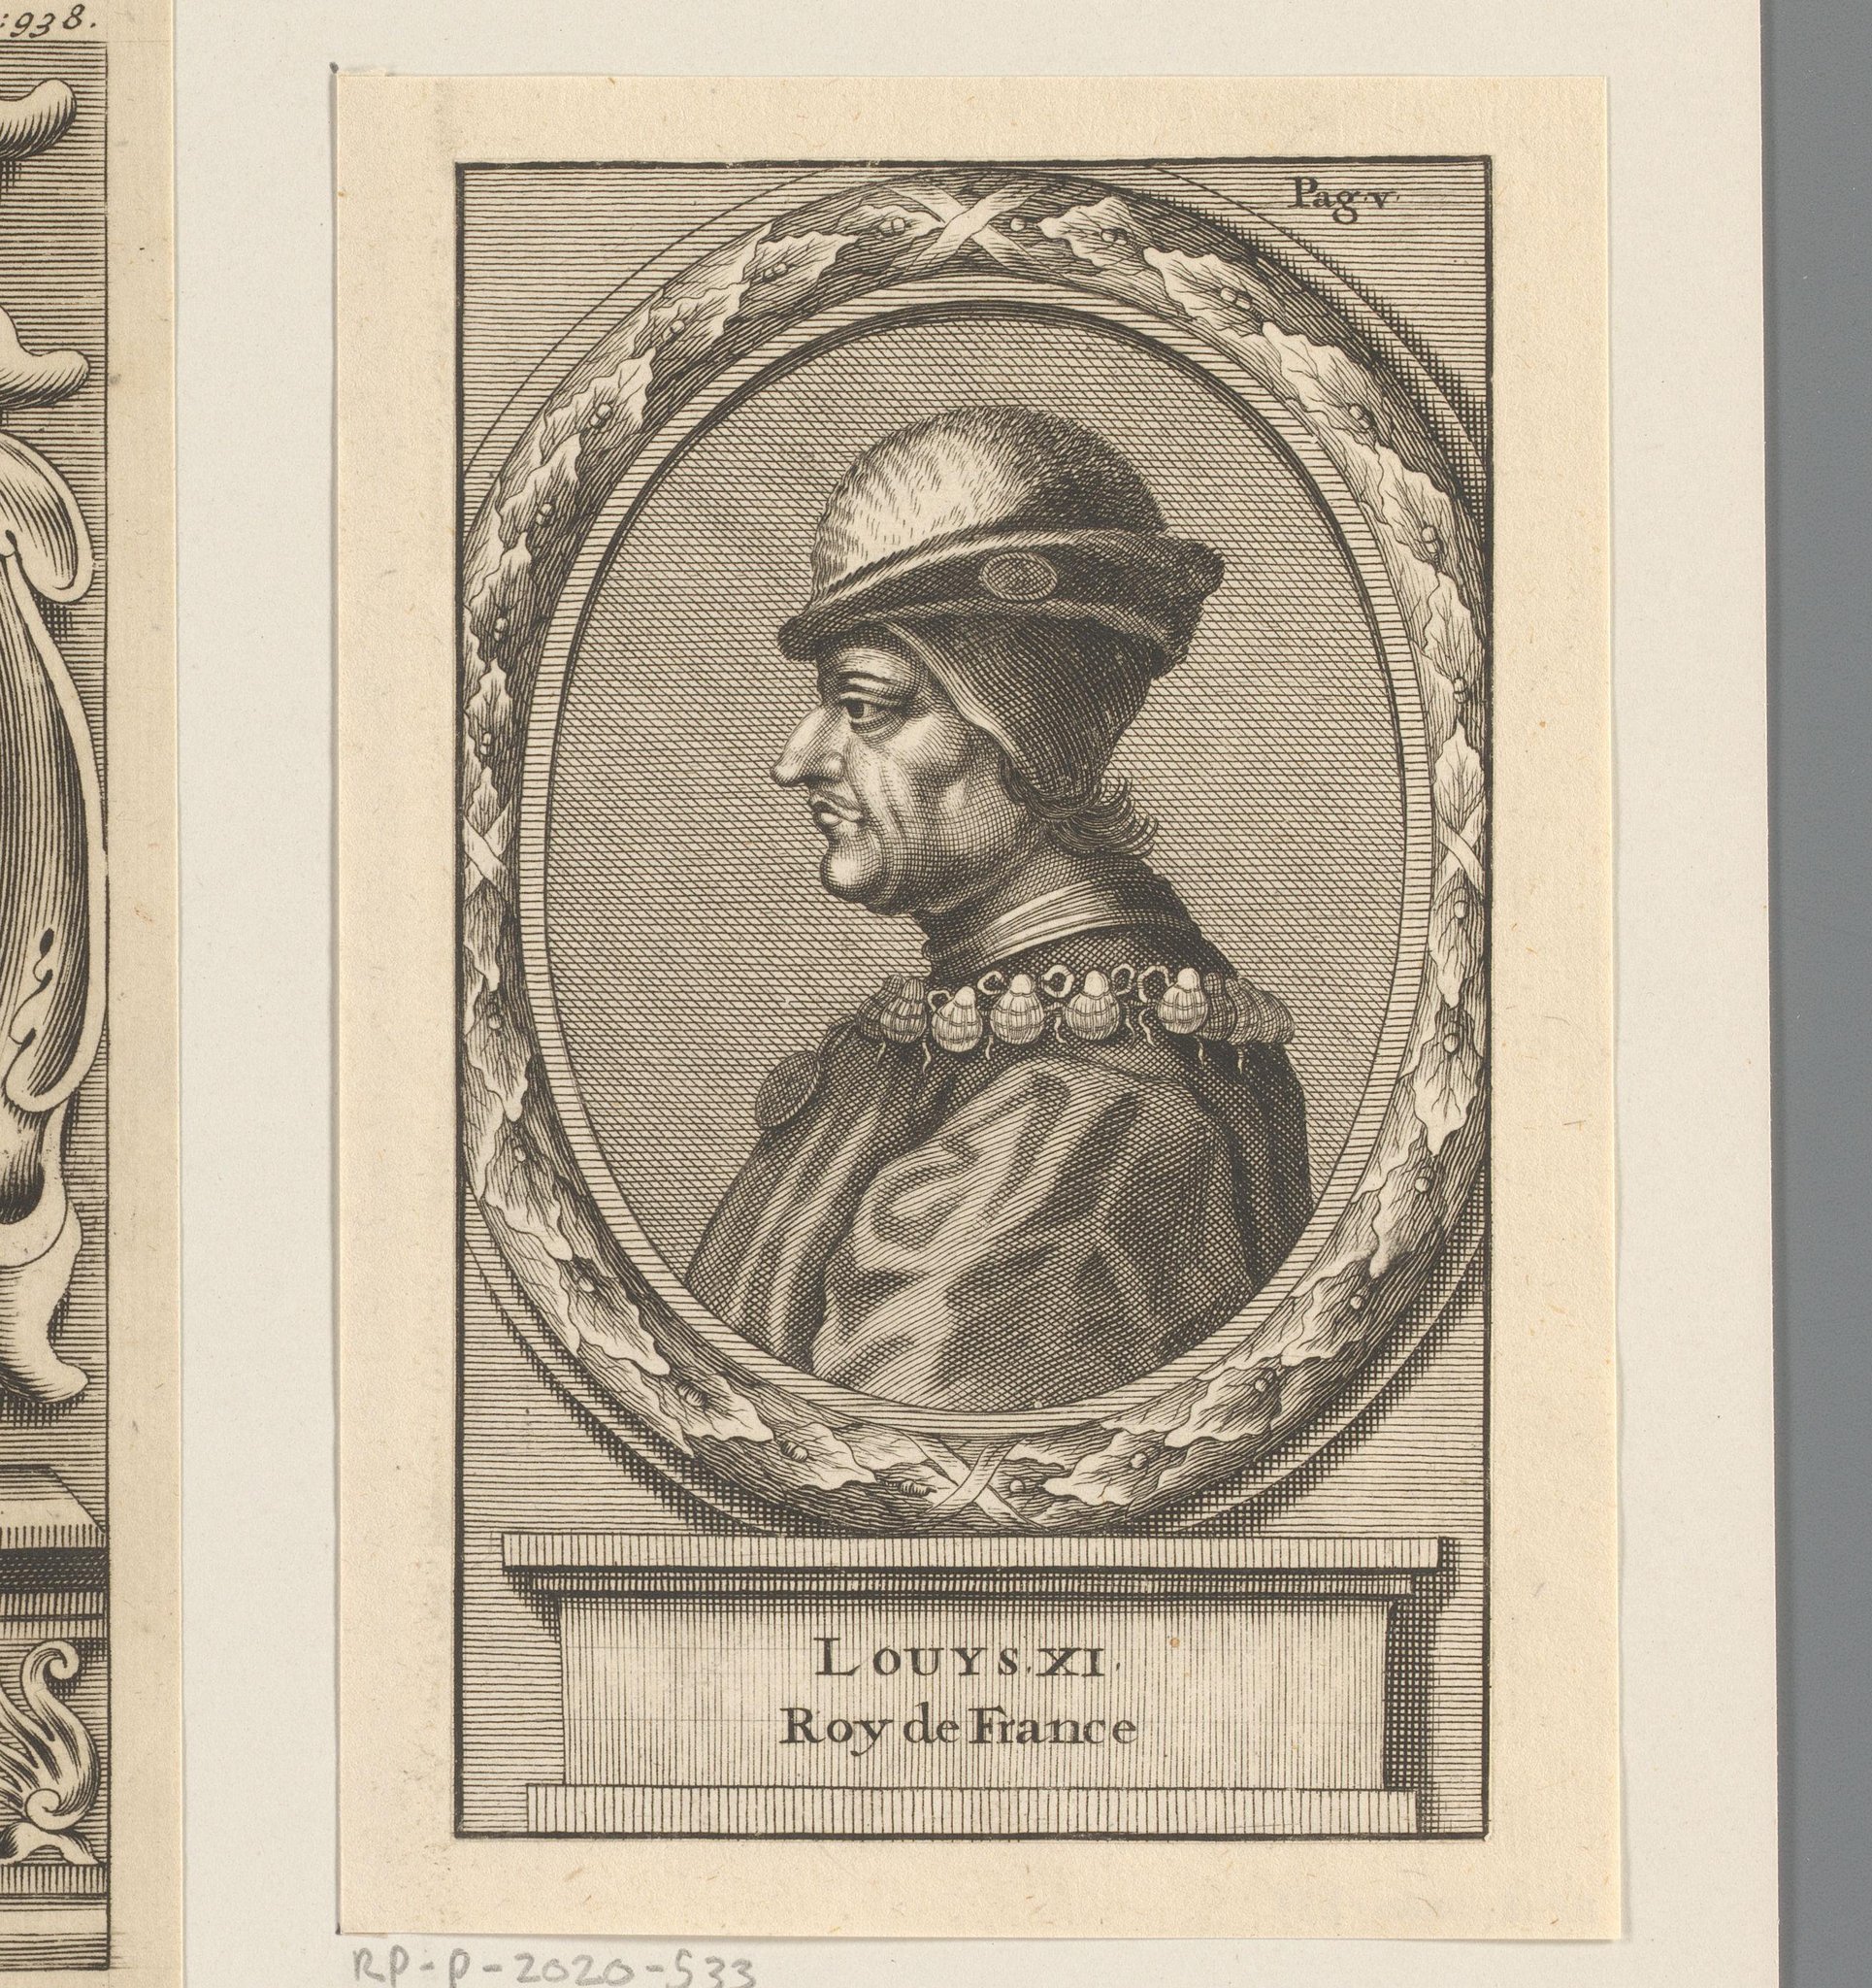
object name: print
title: Louys. XI. Roy de France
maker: Anonymous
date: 1682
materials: paper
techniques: engraving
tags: historical persons, king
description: Prent gebruikt in: Commynes, Philippe de en Godefroy, Denys. Les memoires de messire Philippe de Comines, seigneur d'Argenton, contenans l'histoire des roys Louys XI & Charles VIII (...). 2 dln. Den Haag: Arnout Leers, 1682, dl. 1.